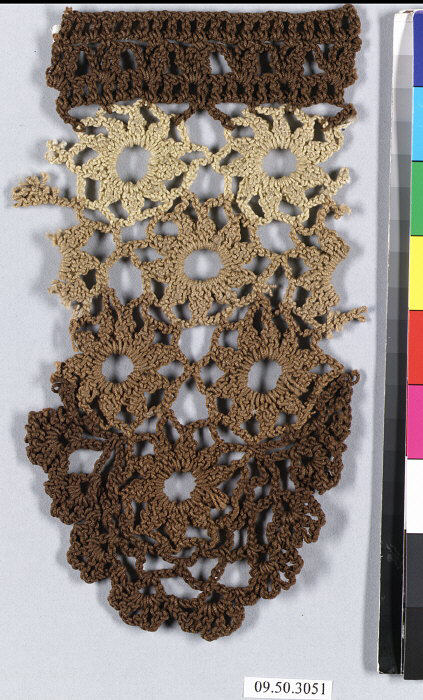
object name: sample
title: Crochet Work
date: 1801-1900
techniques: crochet